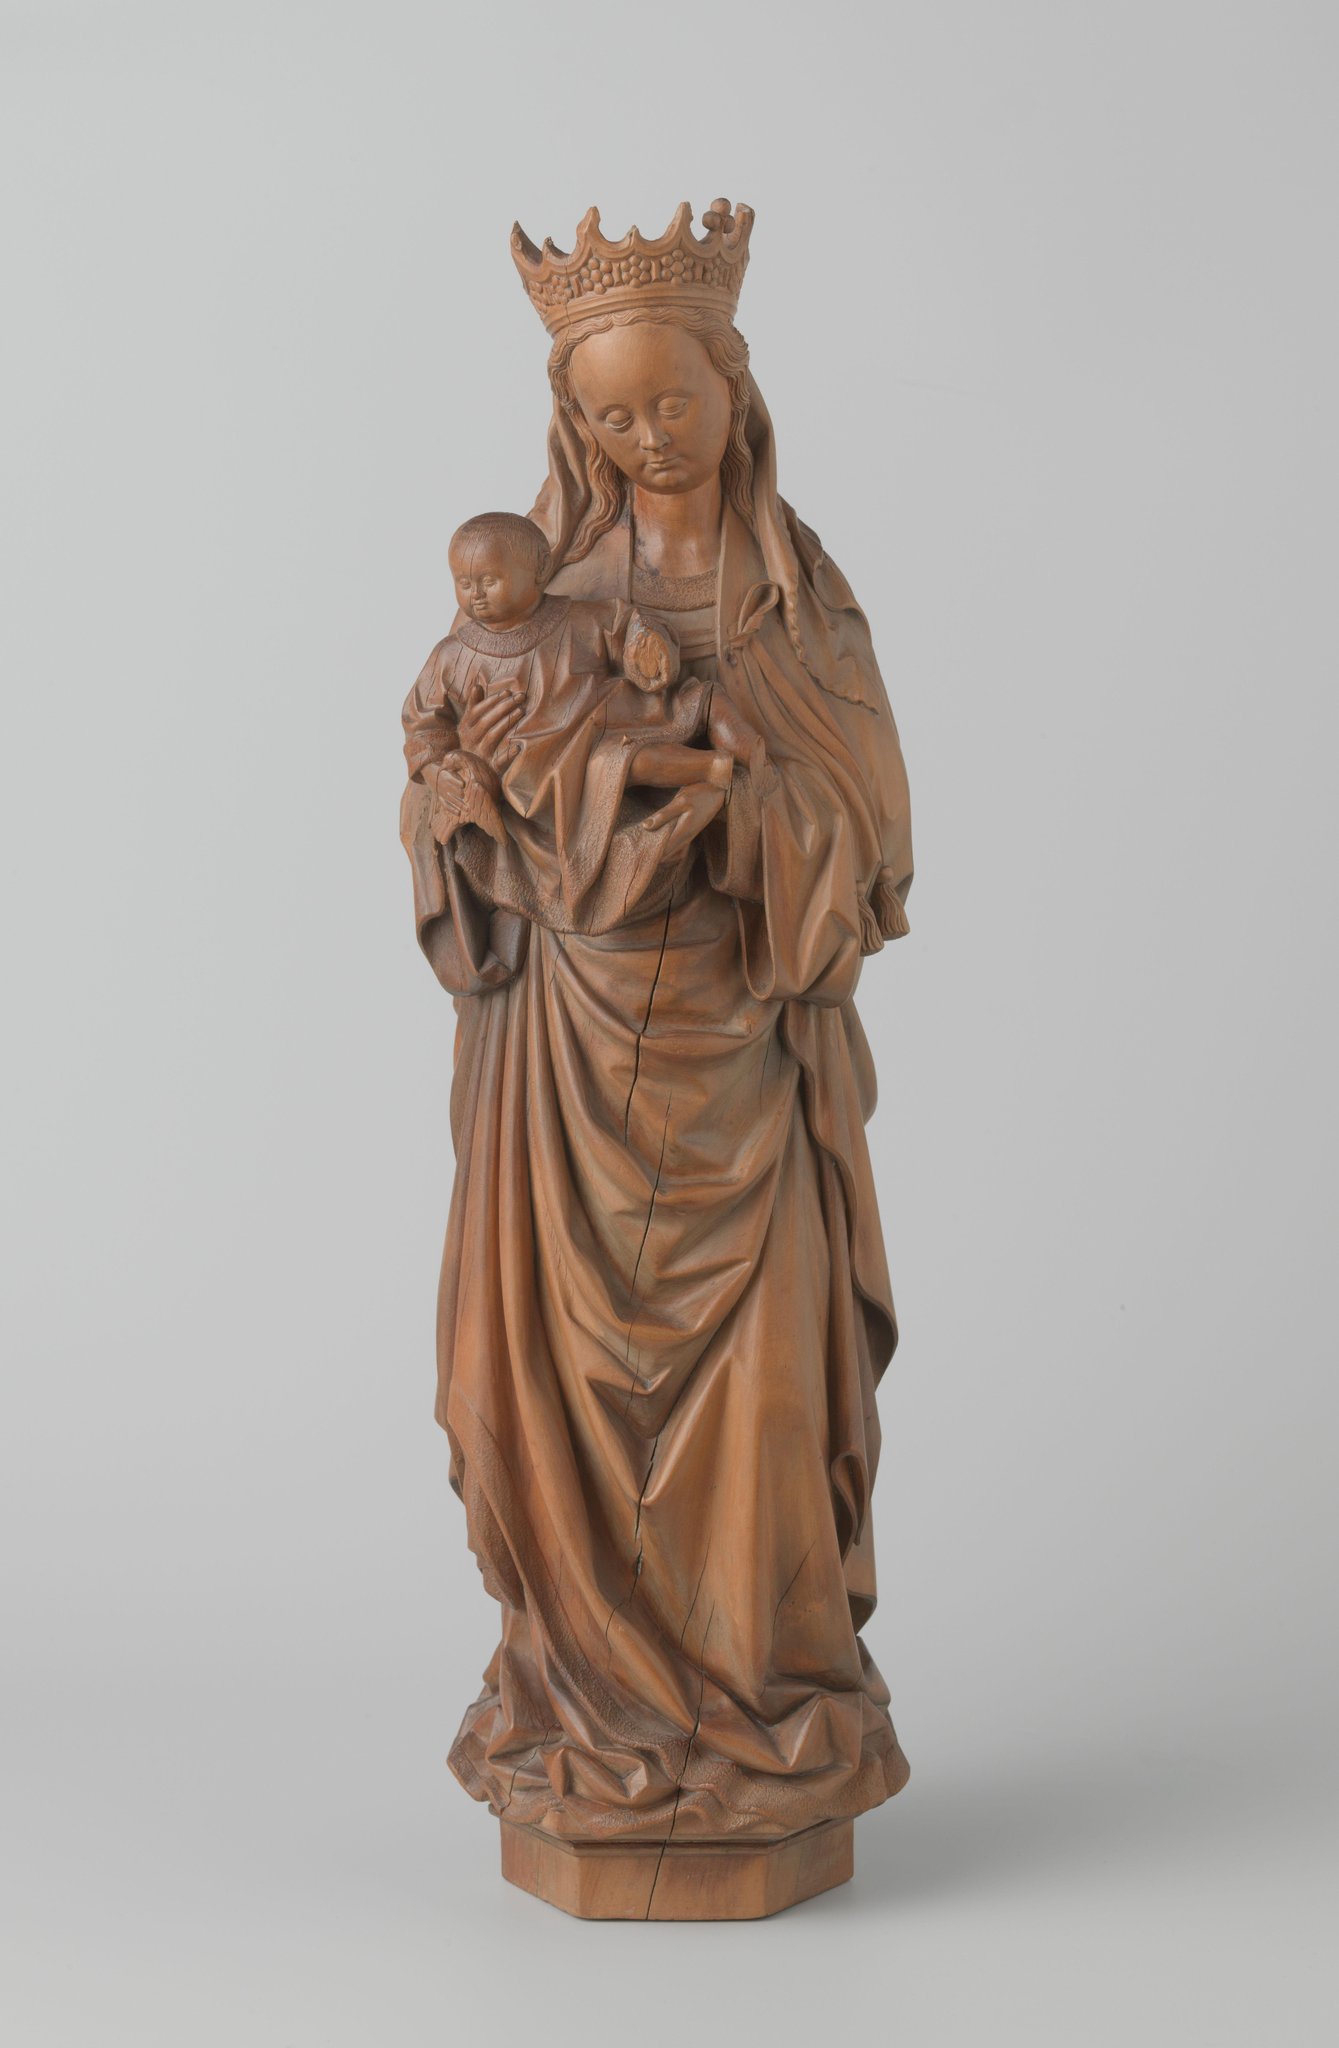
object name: forgery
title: Virgin and Child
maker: nikolaus elscheidt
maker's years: 1835-1874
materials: wood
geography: cologne